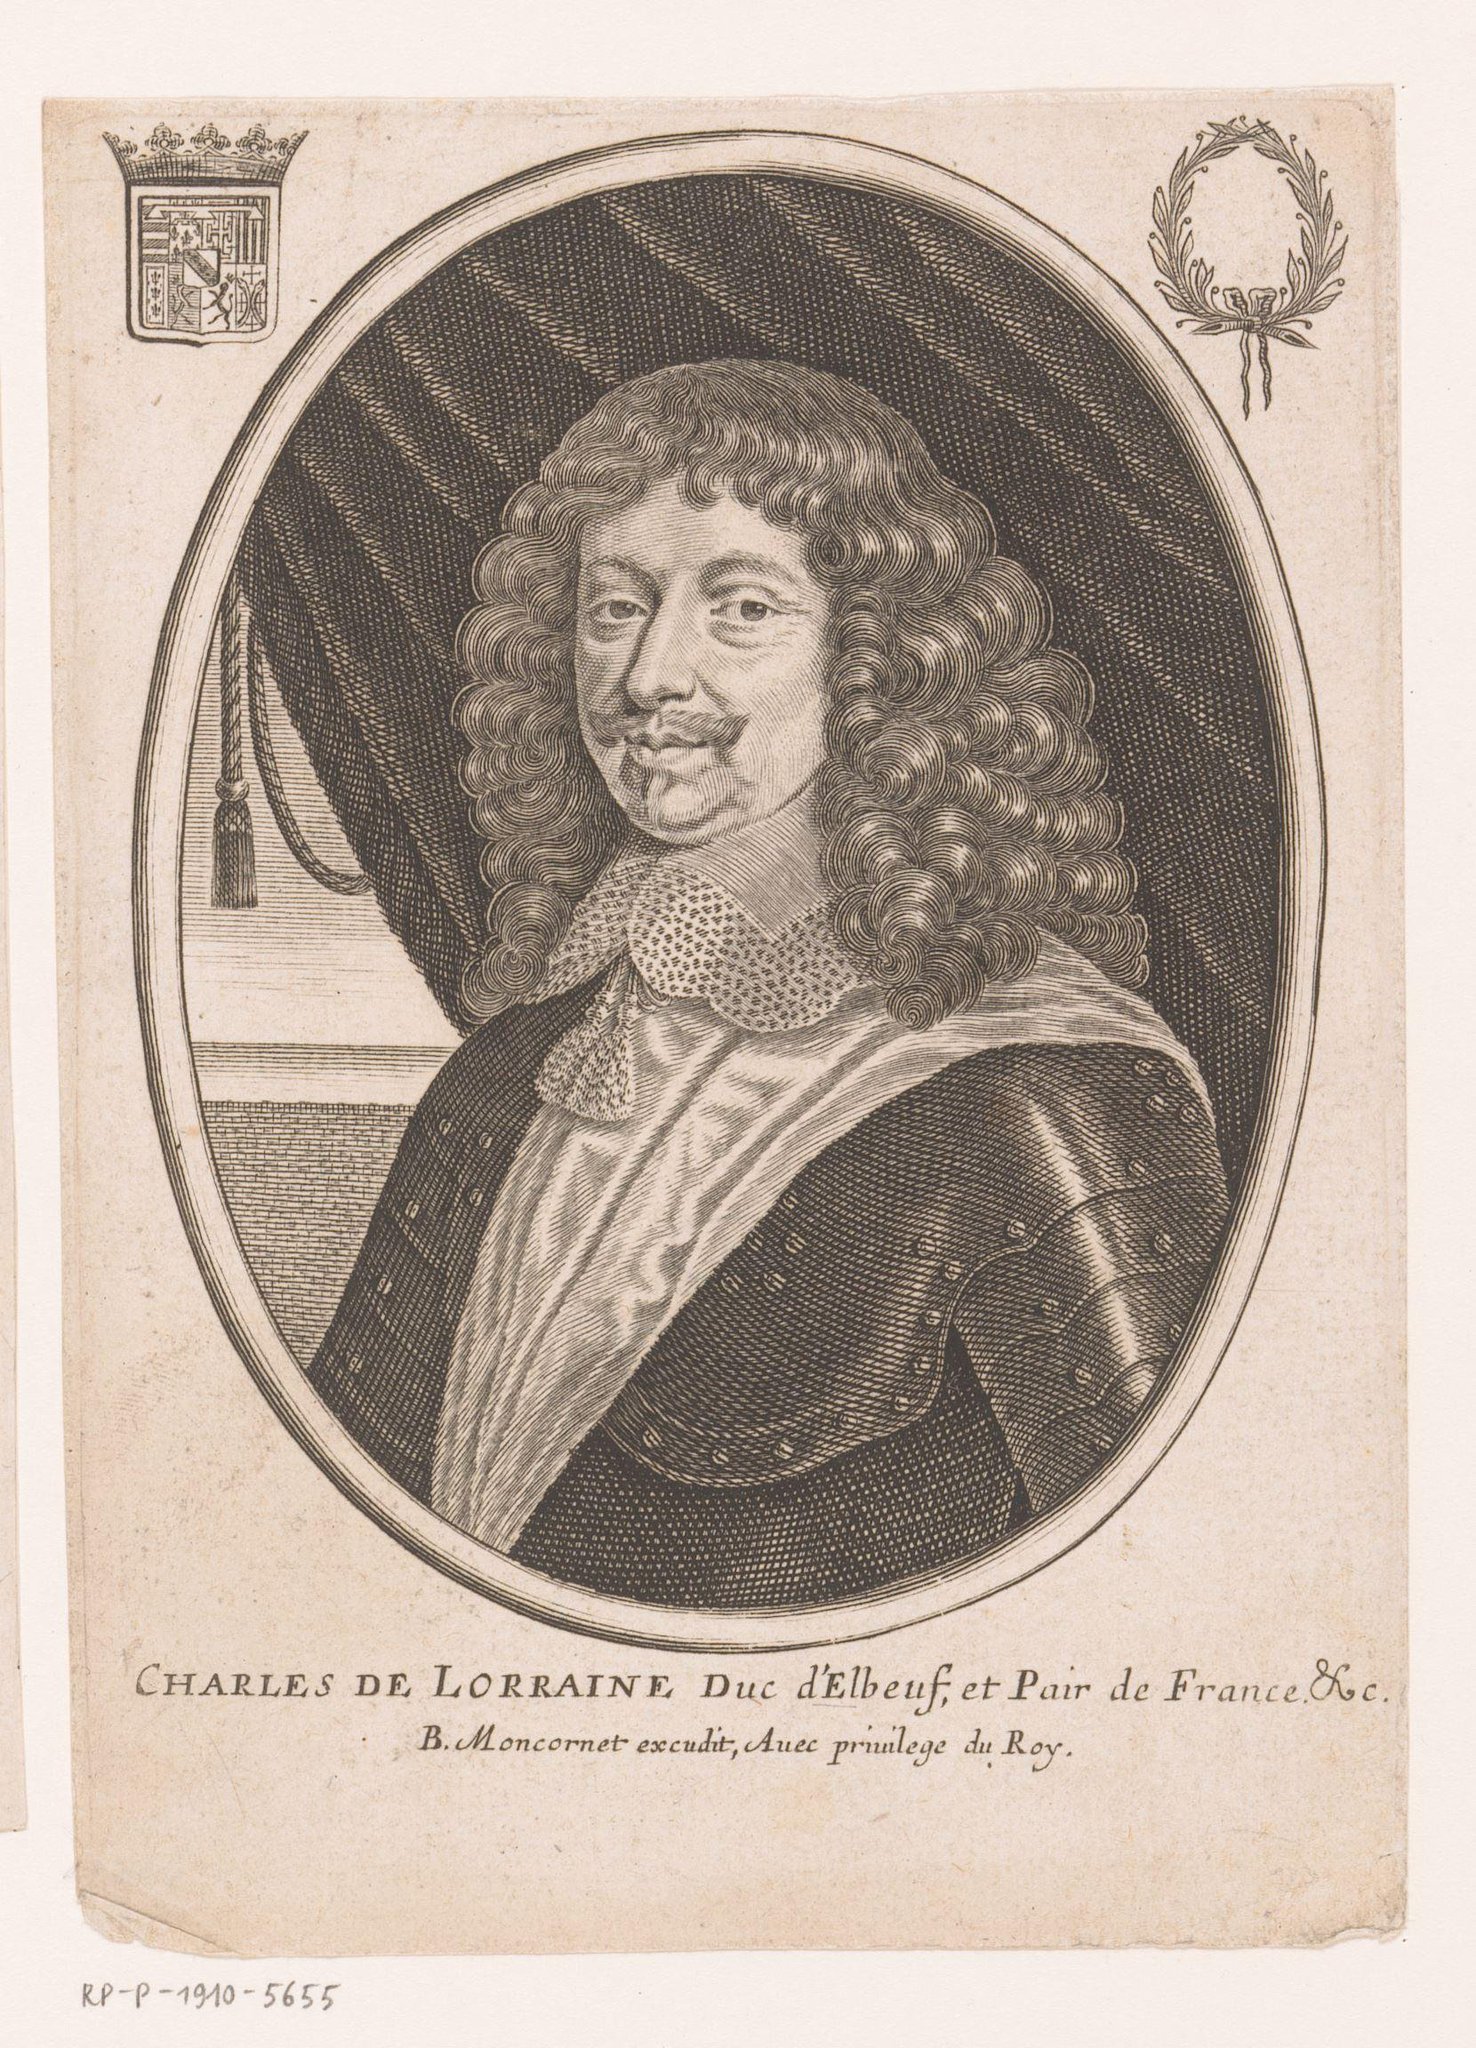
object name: print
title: Portret van Karel IV van Lotharingen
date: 1625-1668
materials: paper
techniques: engraving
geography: france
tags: karel iv hertog van lotharingen, historical persons, nobility and patriciate; chivalry, knighthood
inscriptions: collector's mark: Lugt 2228